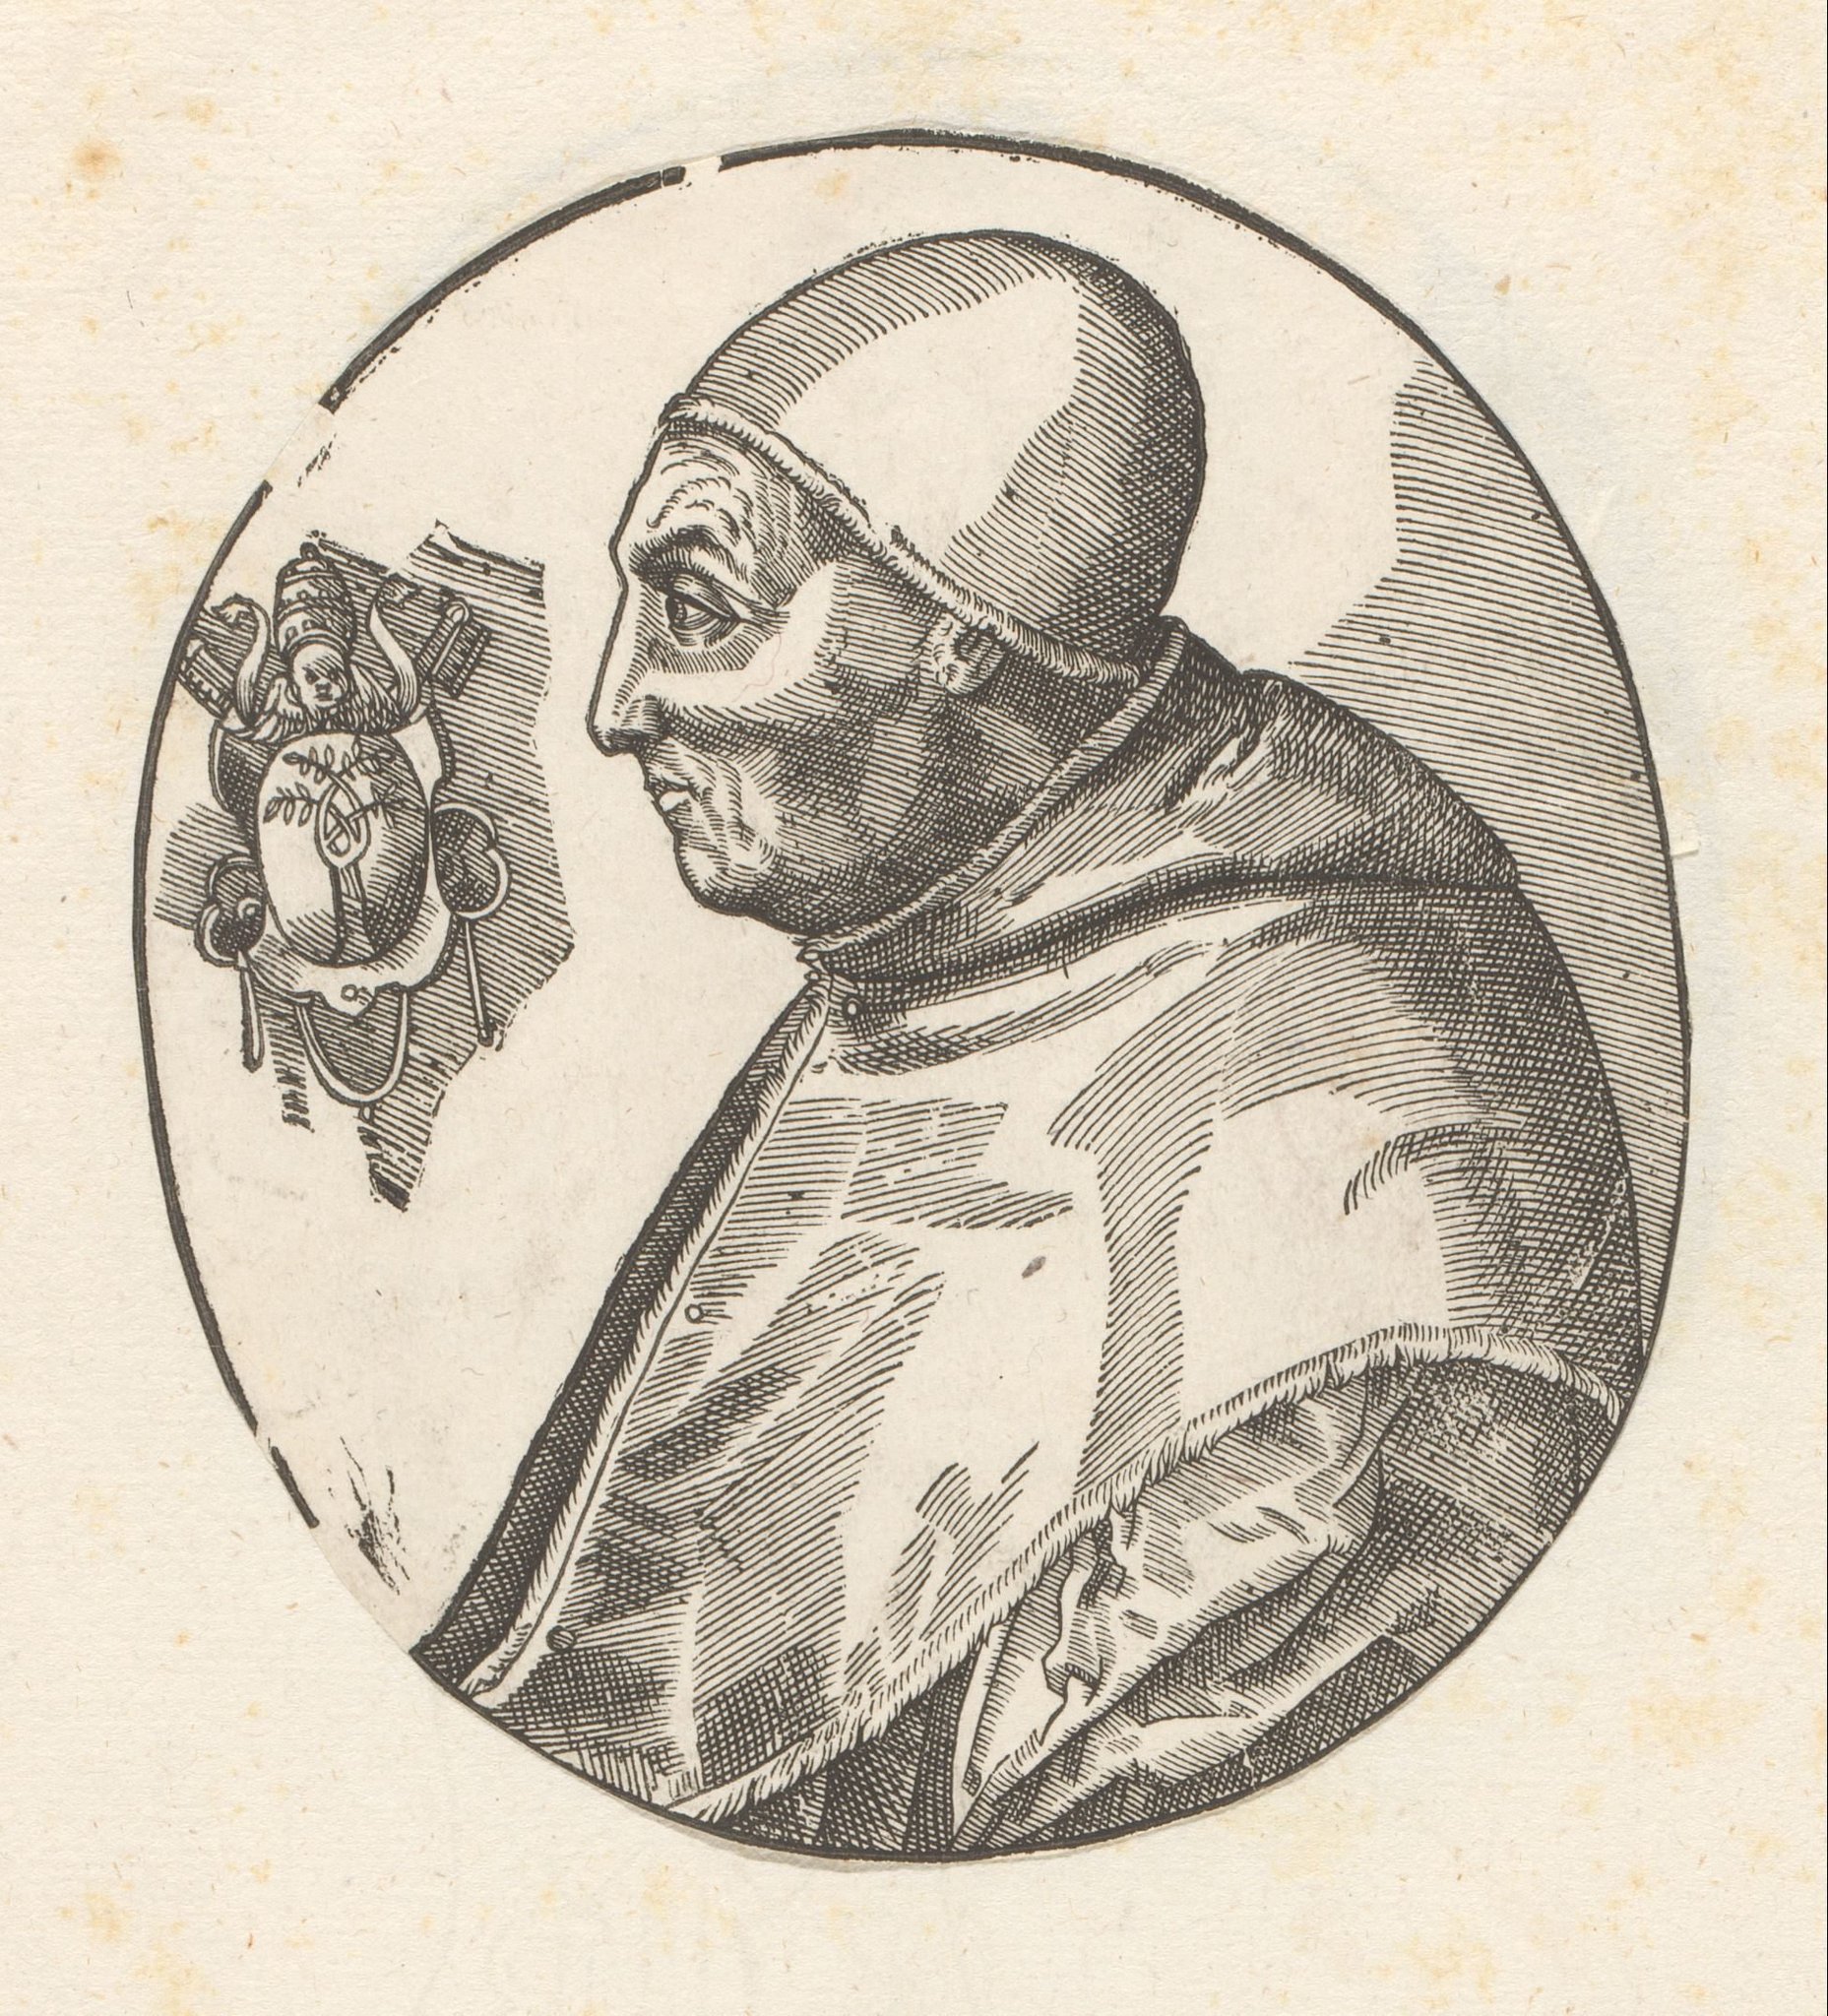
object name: album leaf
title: Portret van paus Sixtus IV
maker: Anonymous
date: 1549-1573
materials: paper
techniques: woodcut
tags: rome, historical persons, pope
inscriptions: collector's mark: Lugt 240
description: Prent gebruikt in: Panvinio, Onofrio. Accuratae Effigies Pontificum (...). Straatsburg: Bernhard Jobin, 1573.